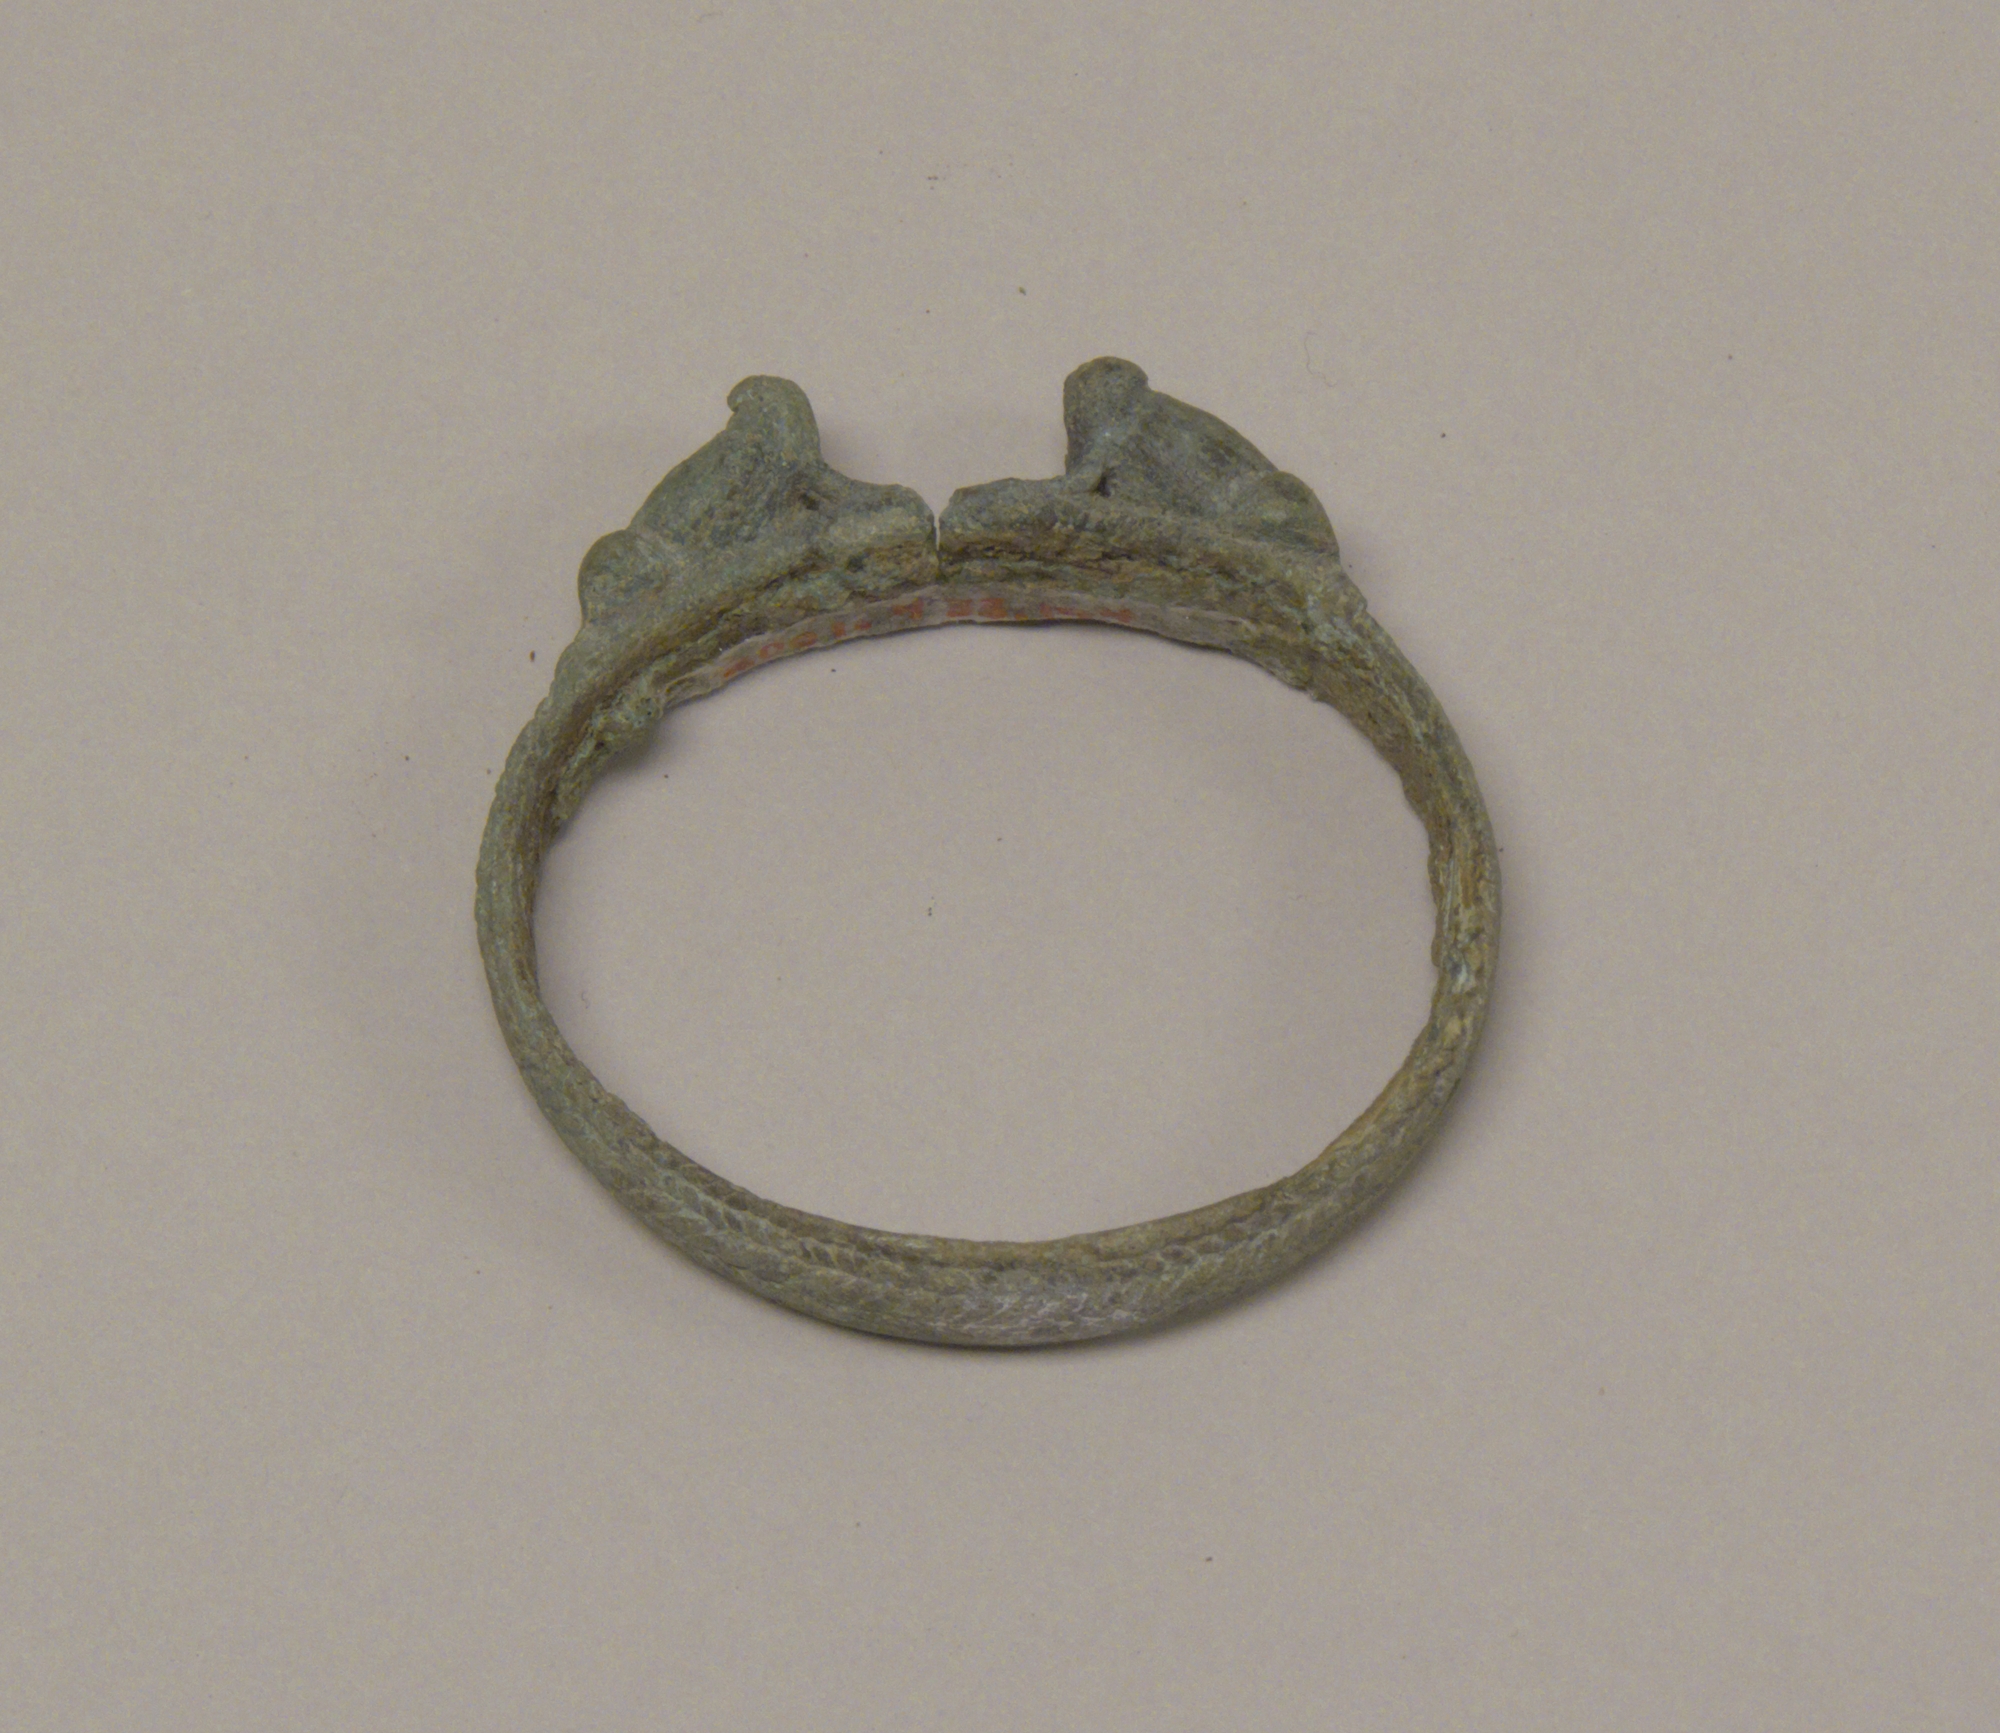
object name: bracelet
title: Open Bracelet with Two Facing Frogs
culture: thai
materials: bronze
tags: frogs